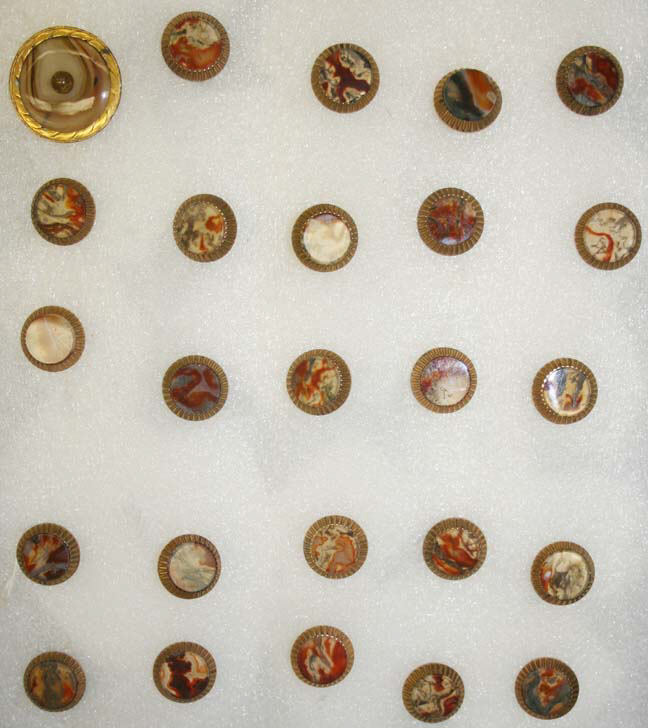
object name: button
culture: american or european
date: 1800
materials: metal, paste